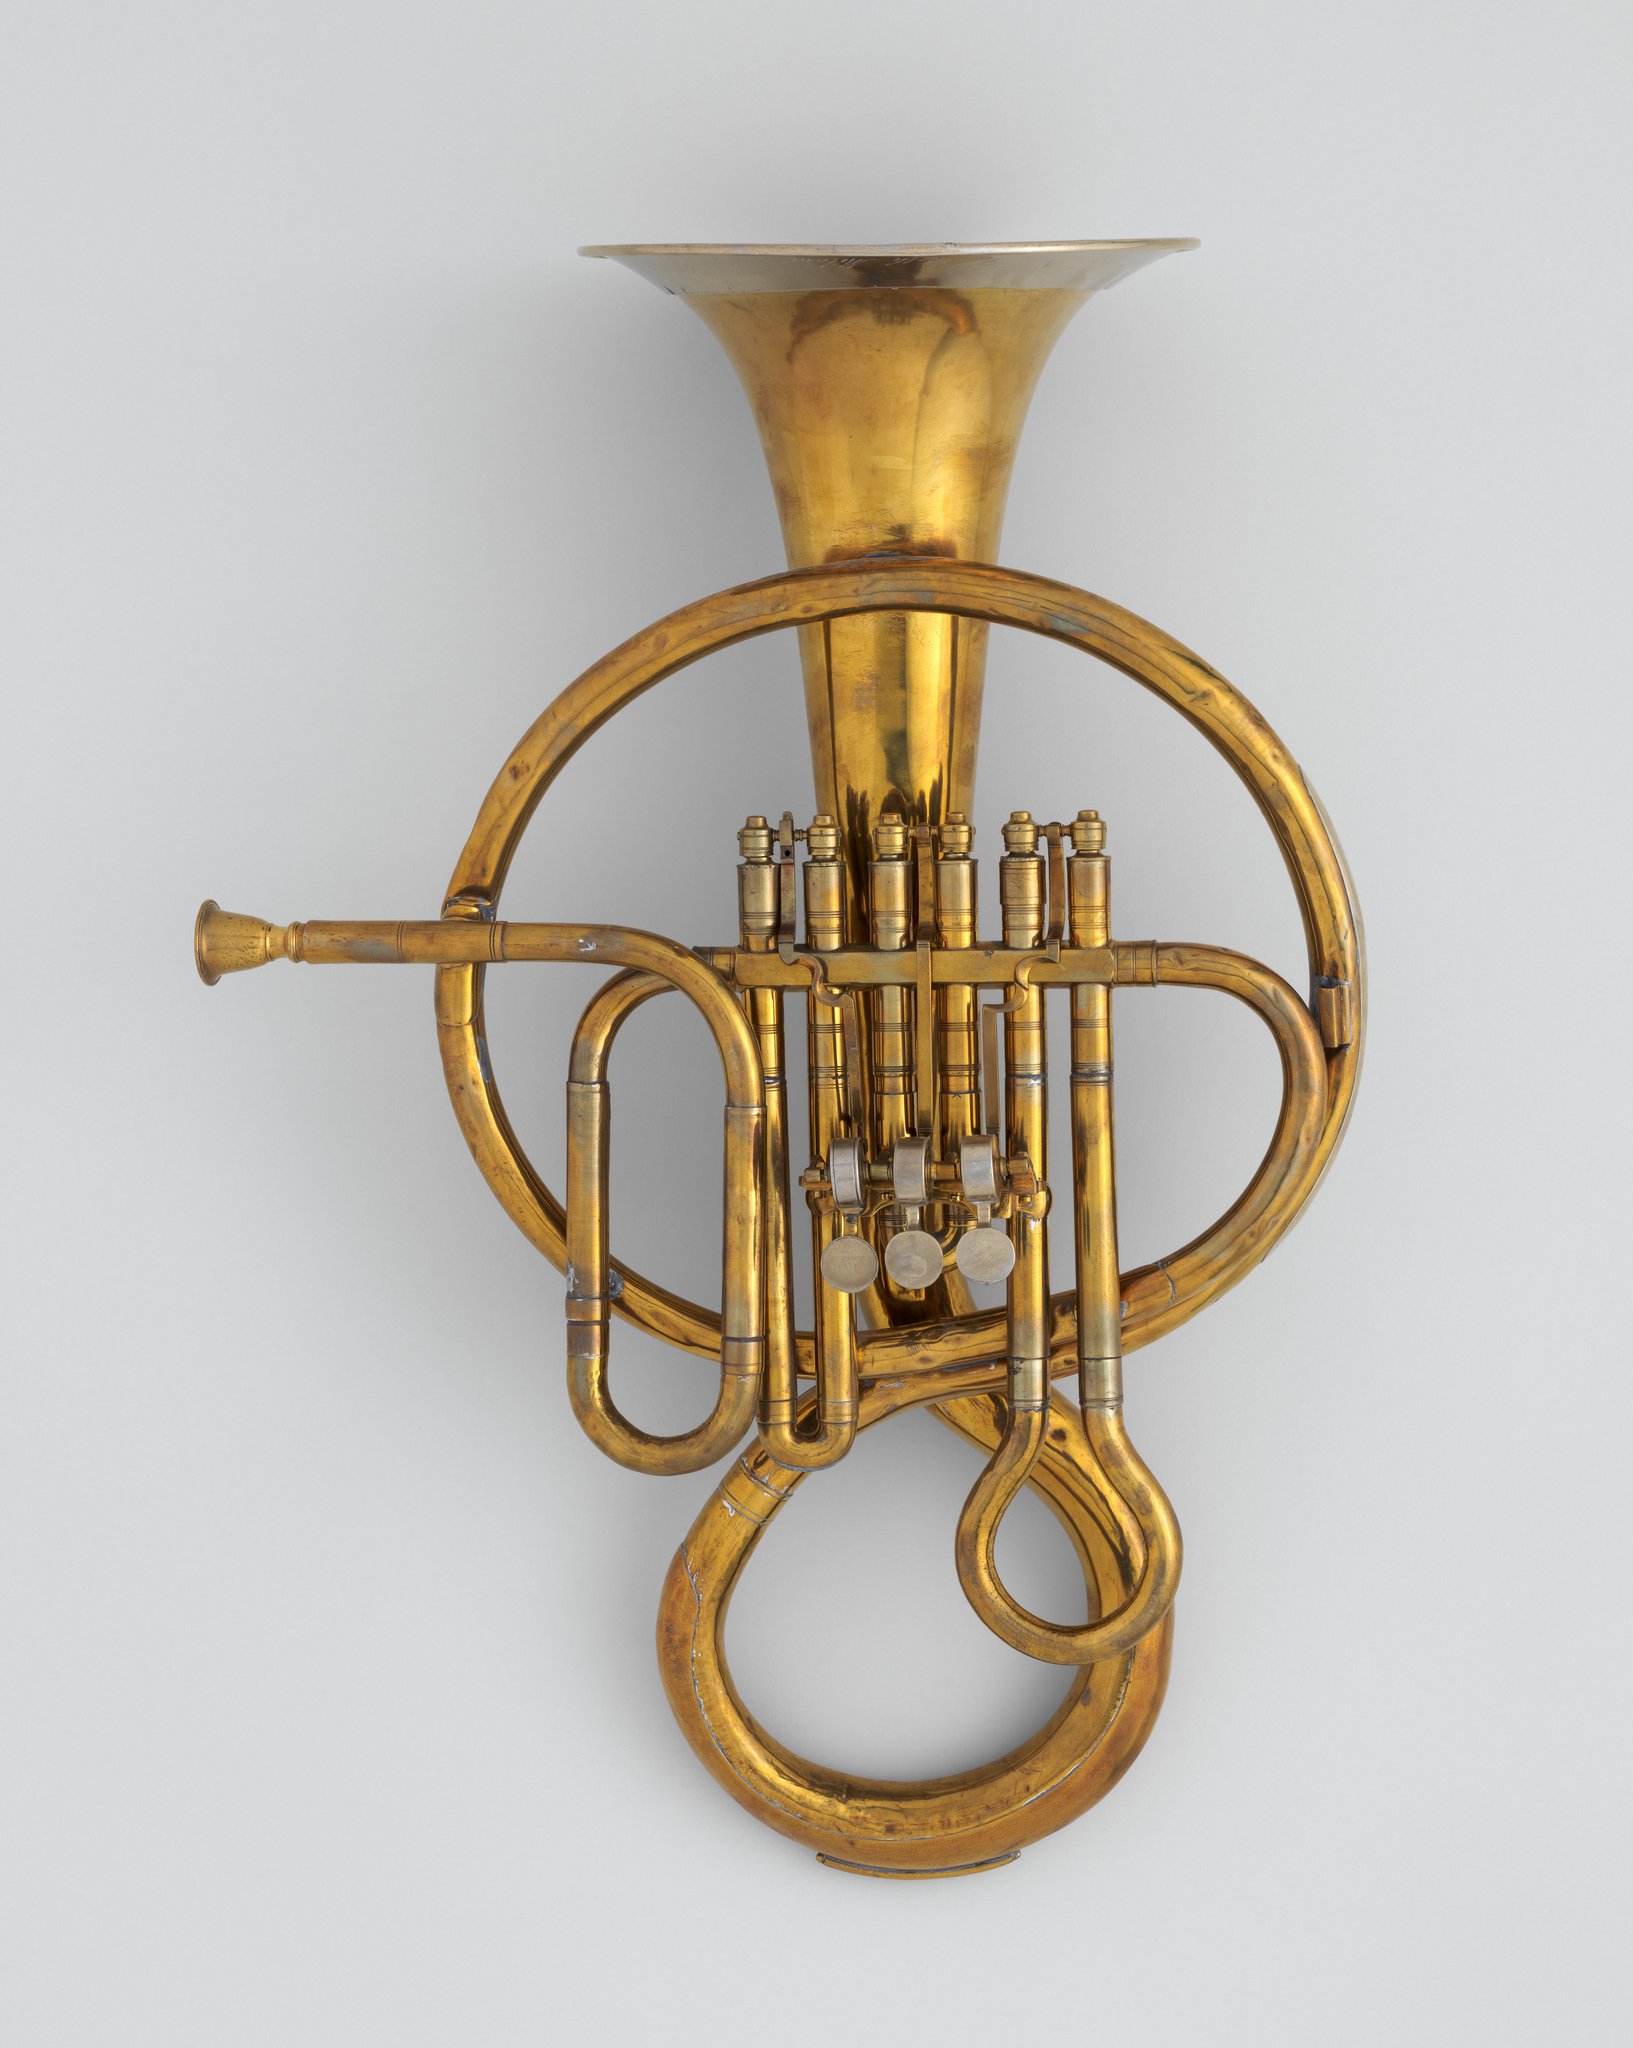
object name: bass fluegel horn in b flat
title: Bass Fluegel Horn in B-flat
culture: italian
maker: ferdinando roth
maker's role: maker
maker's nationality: italian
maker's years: 1815-1898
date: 1855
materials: brass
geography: italy